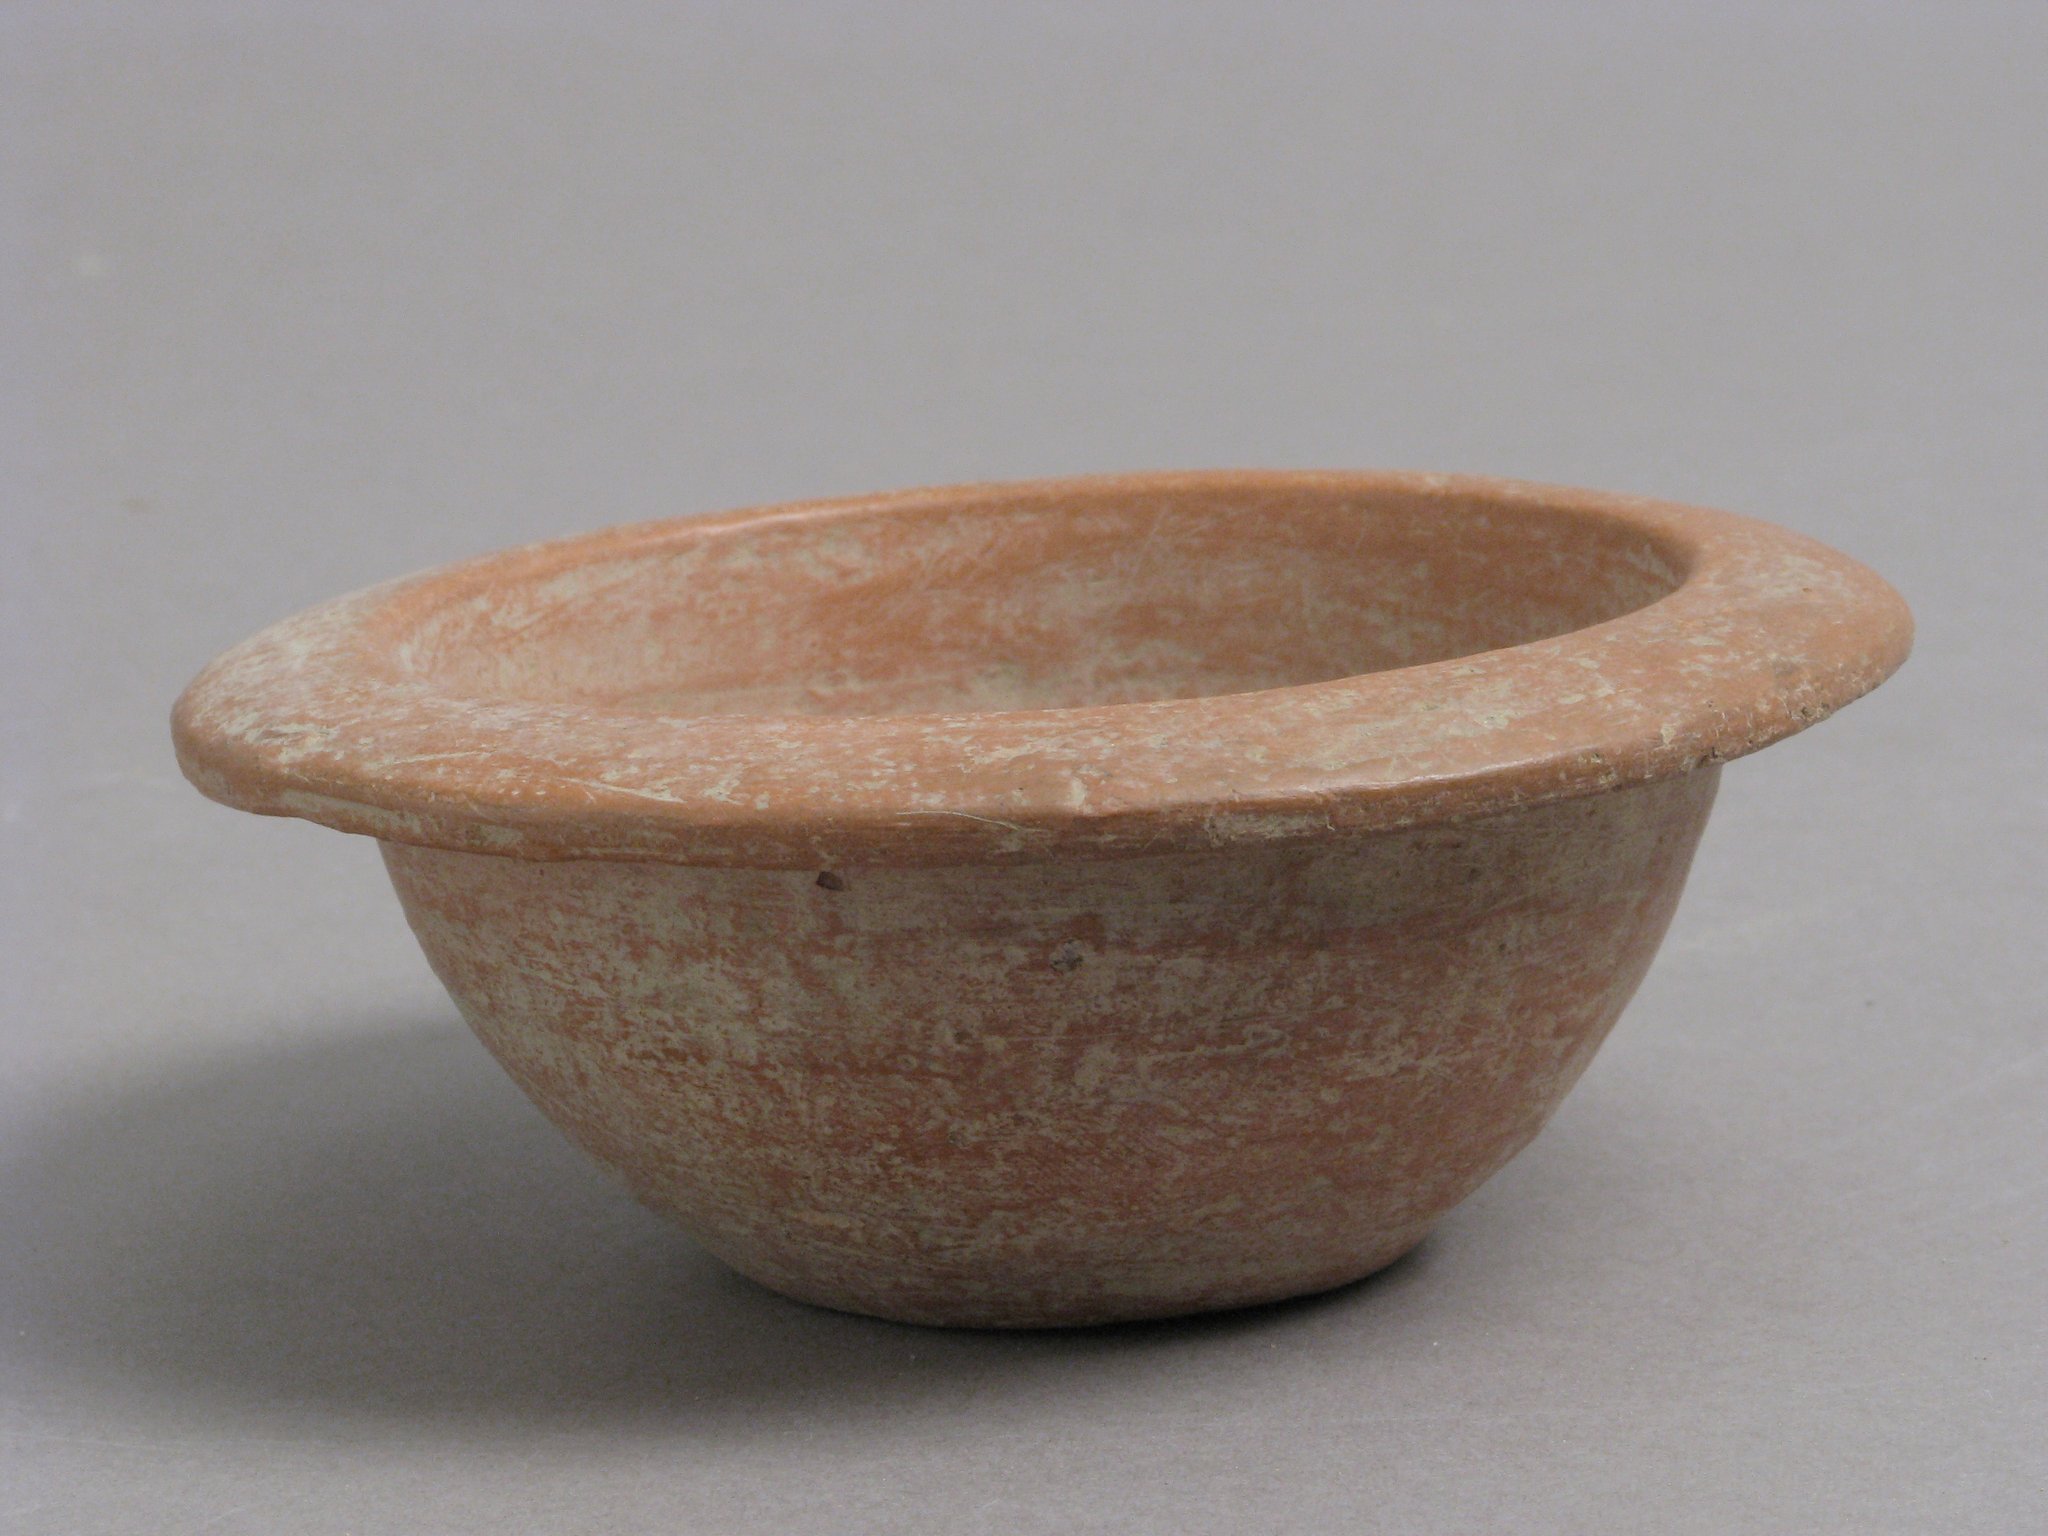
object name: bowl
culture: coptic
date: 301-700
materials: earthenware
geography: egypt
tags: bowls